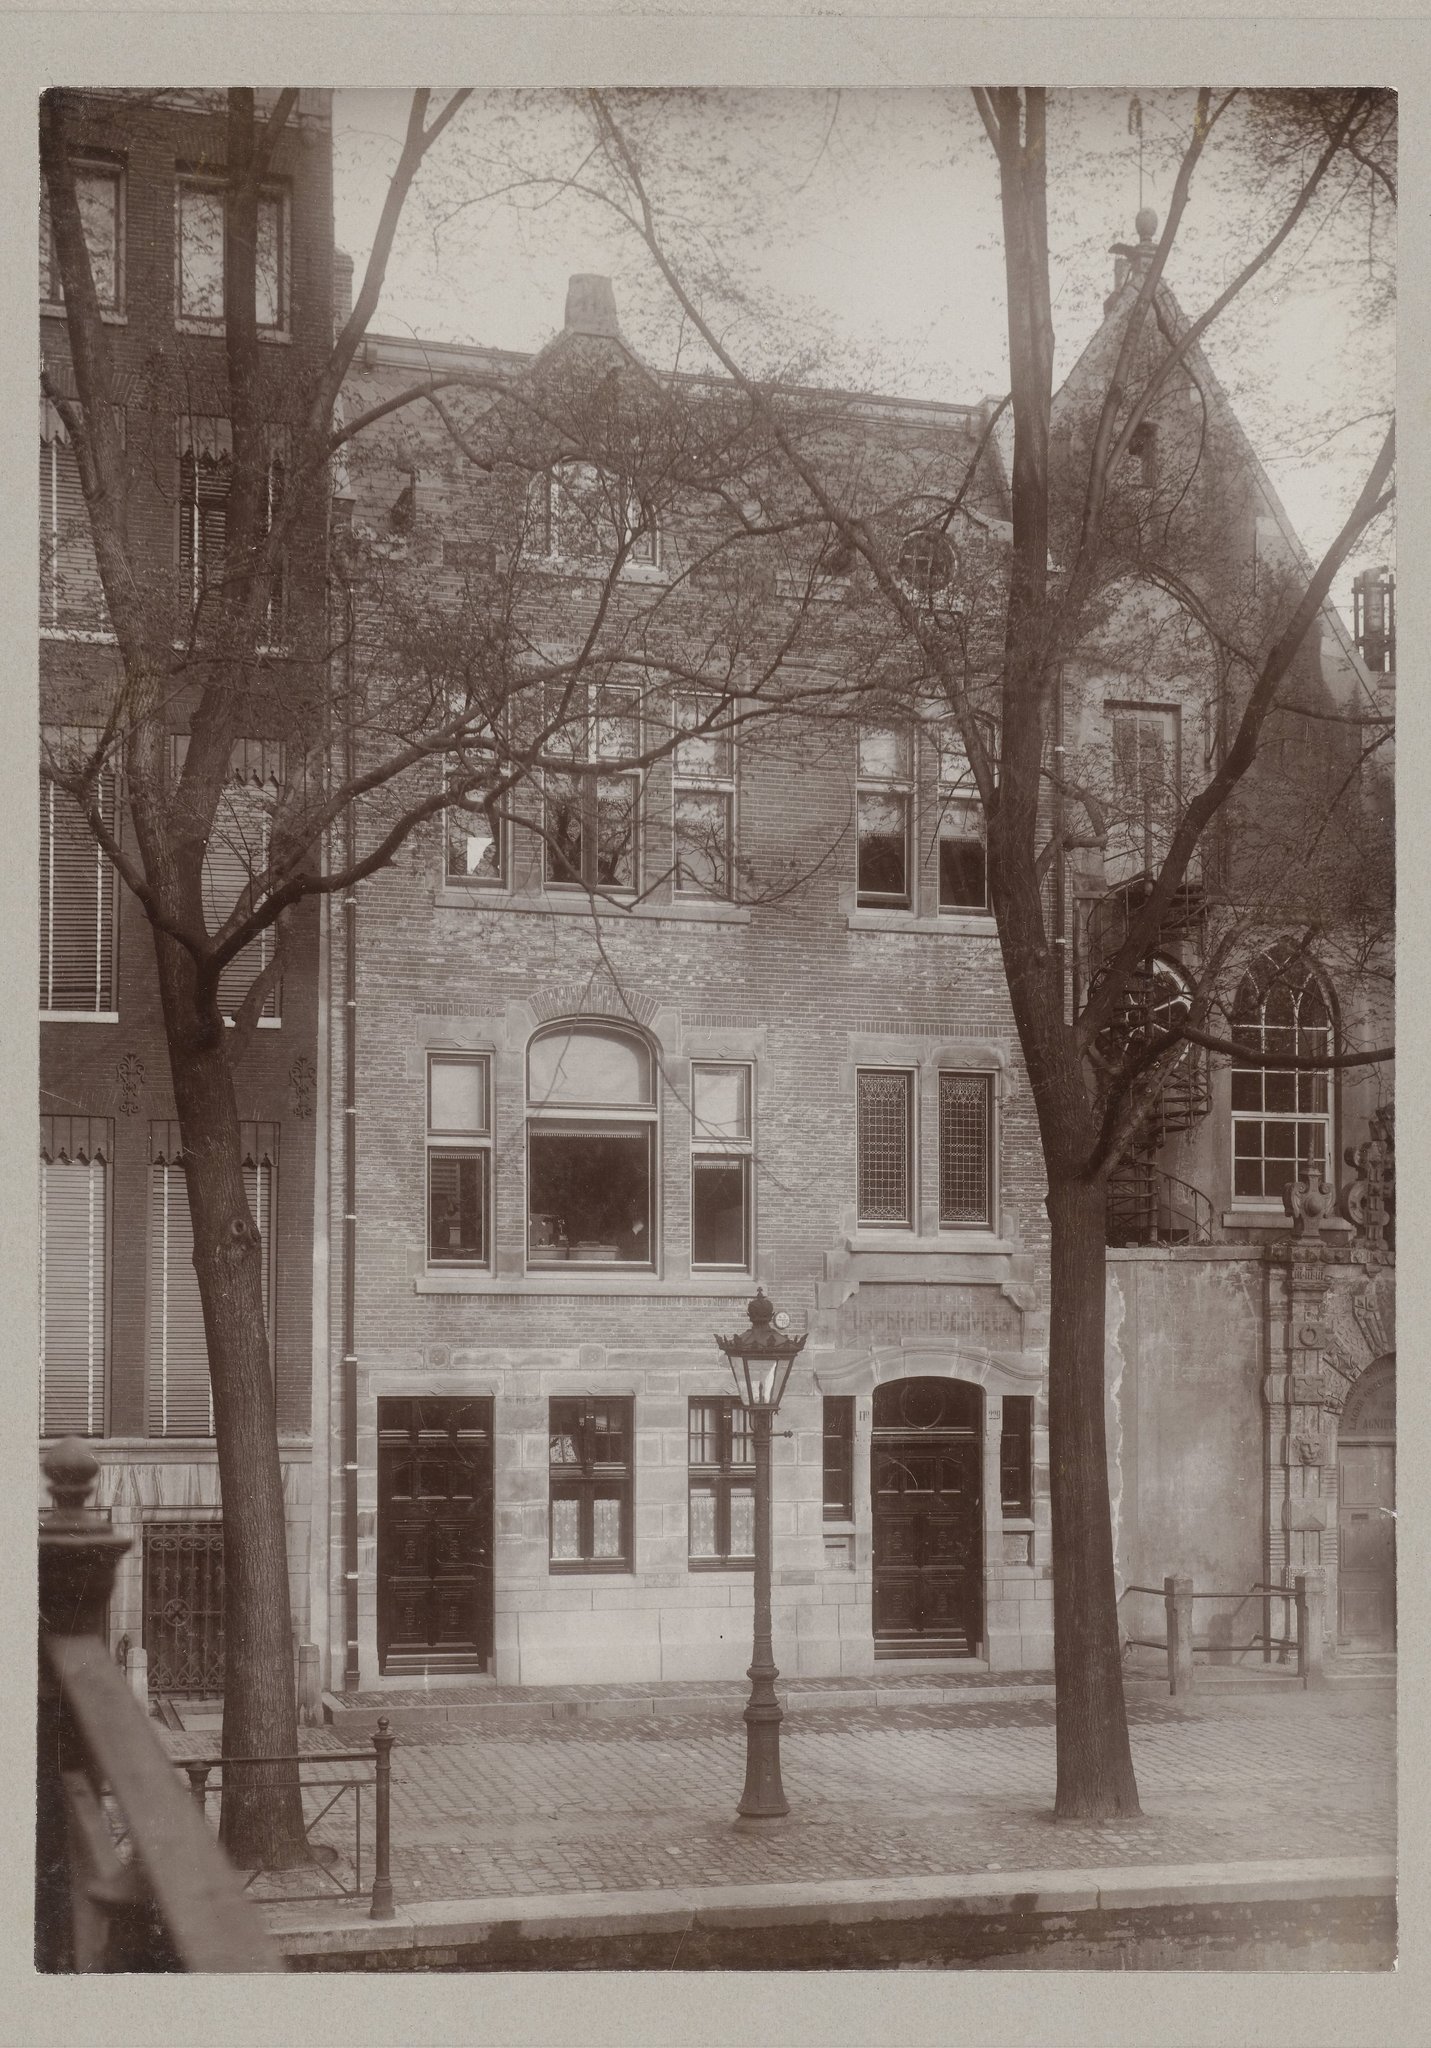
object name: photograph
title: Pakhuis van het Purperhoedenveem aan de Oudezijds Voorburgwal 229 naast de Agnietenkapel/Agnietenschool, Amsterdam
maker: cornelis johannes steenbergh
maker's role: fotograaf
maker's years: 1859-1939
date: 1890-1920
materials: cardboard, paper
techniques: collodion silver print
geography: amsterdam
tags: city-view, and landscape with man-made constructions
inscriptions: stamp: ‘C. Steenbergen, Kalverstraat 219 bij de munt’